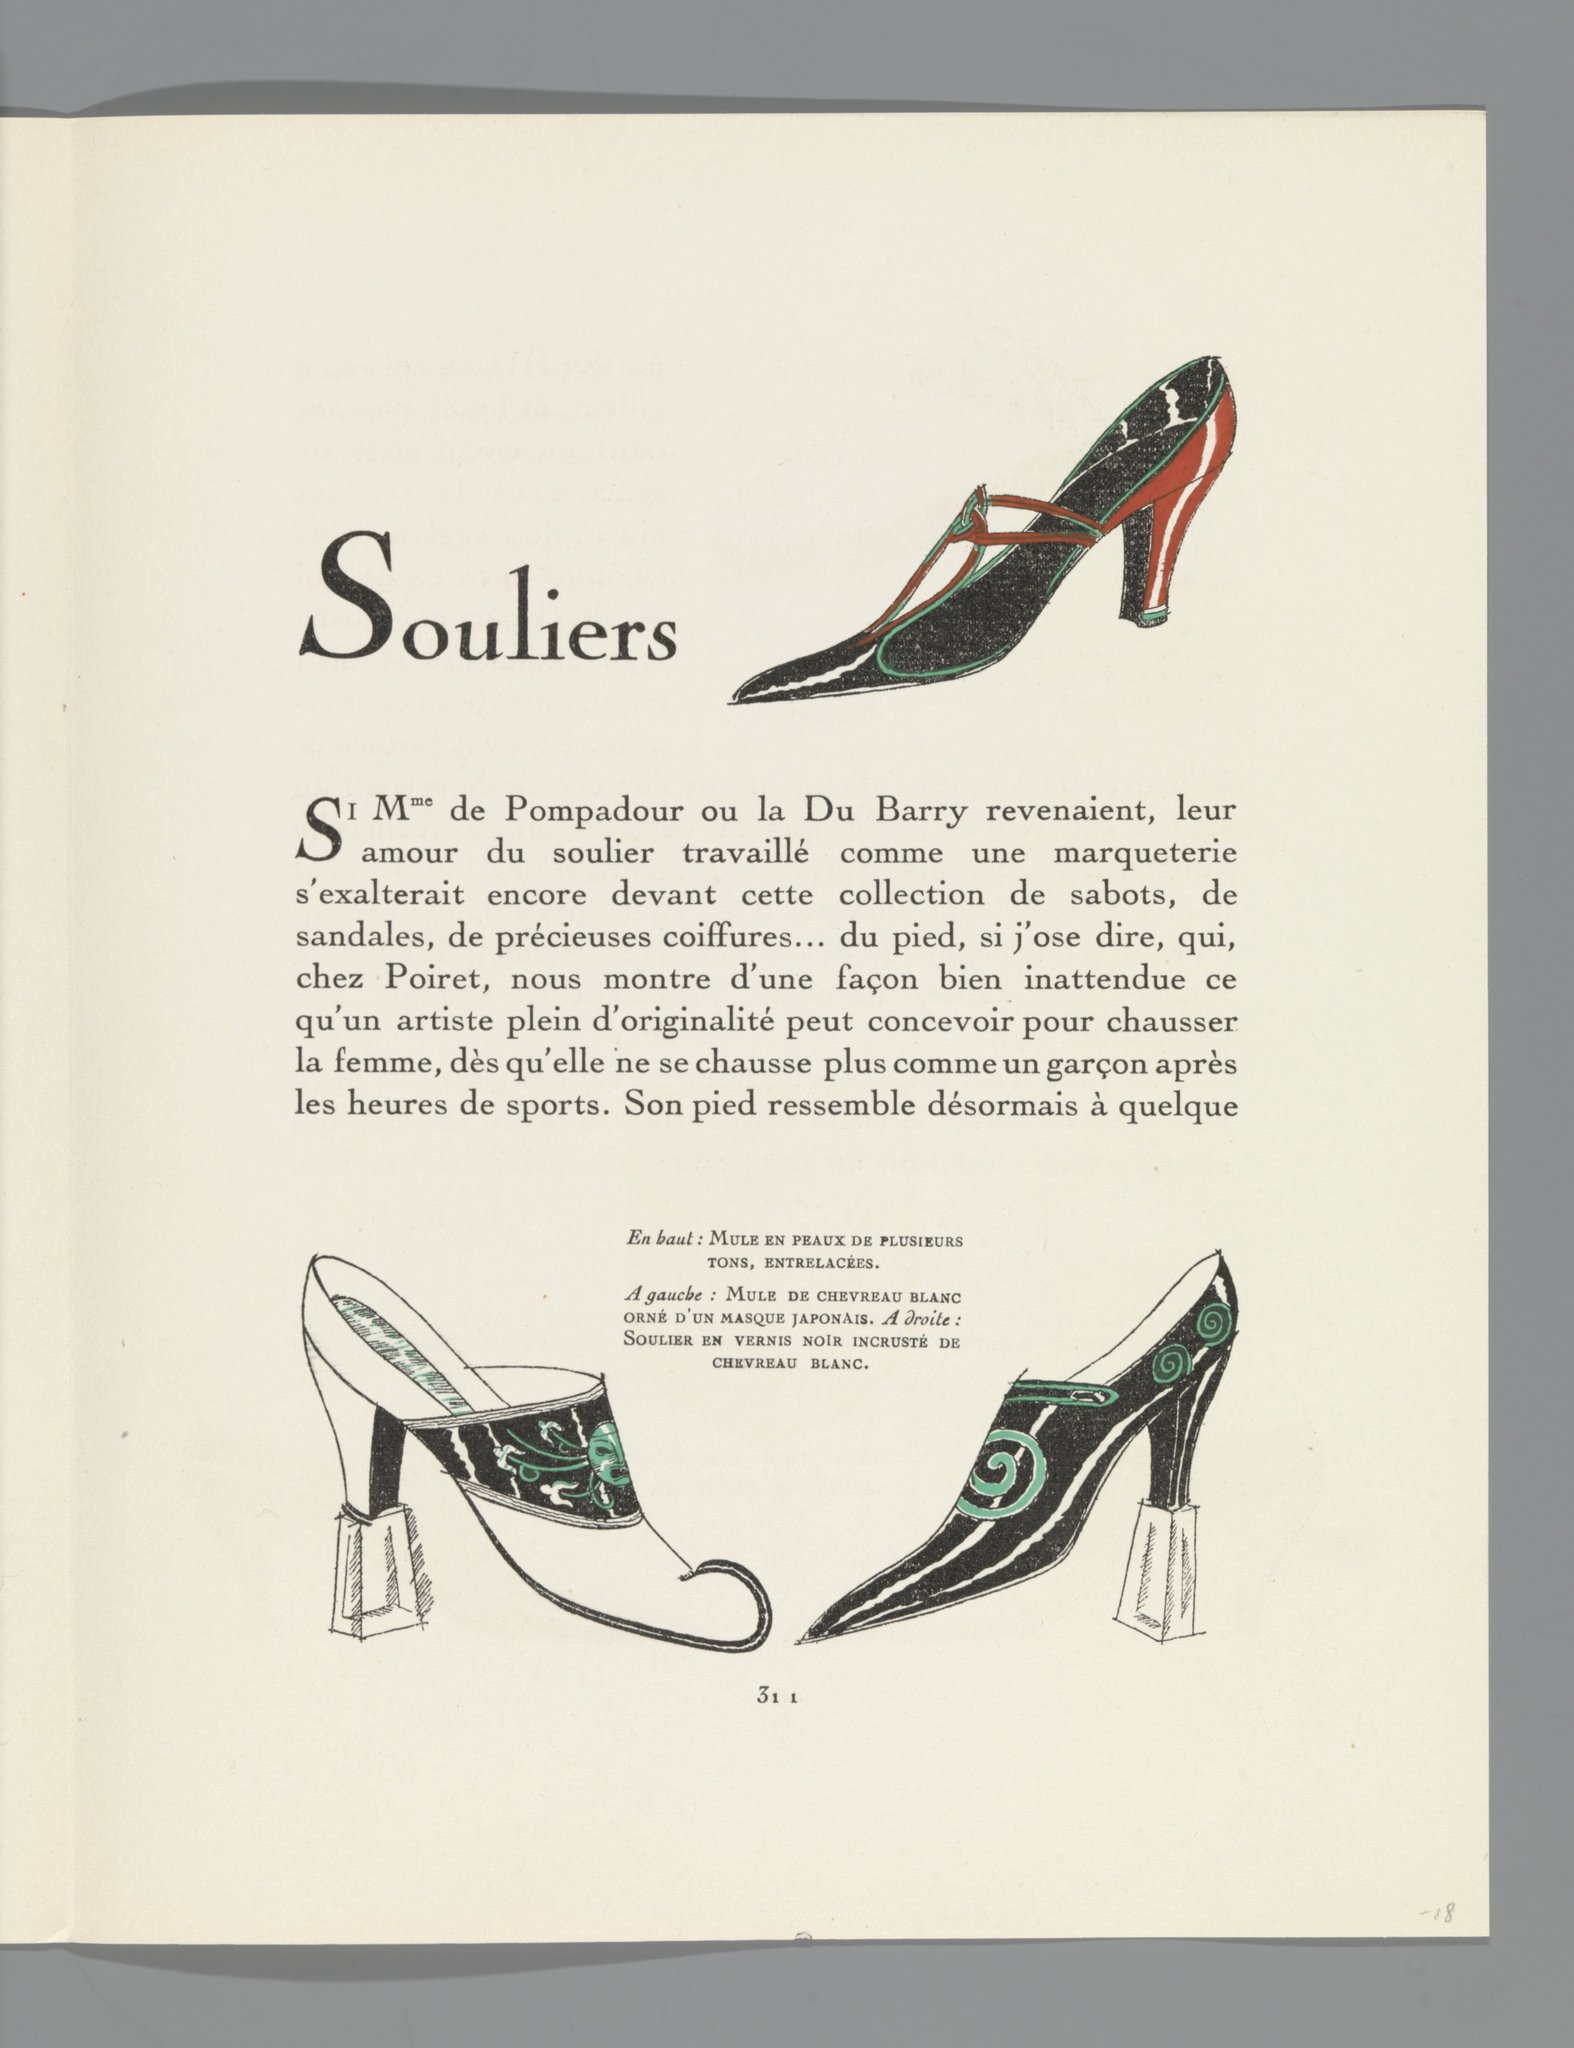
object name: fashion print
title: Gazette du Bon Ton, 1921 - No. 10, p. 311: "Souliers" : damesschoenen van Pérugia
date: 1921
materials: paper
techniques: hand coloring, letterpress printing, lithograph, photochemical processes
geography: paris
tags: fashion plates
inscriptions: date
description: Pag. 311: "Souliers". Tekst over damesschoenen van Pérugia. Twee illustraties van pumps, een van een muiltje, versierd met een Japans masker.